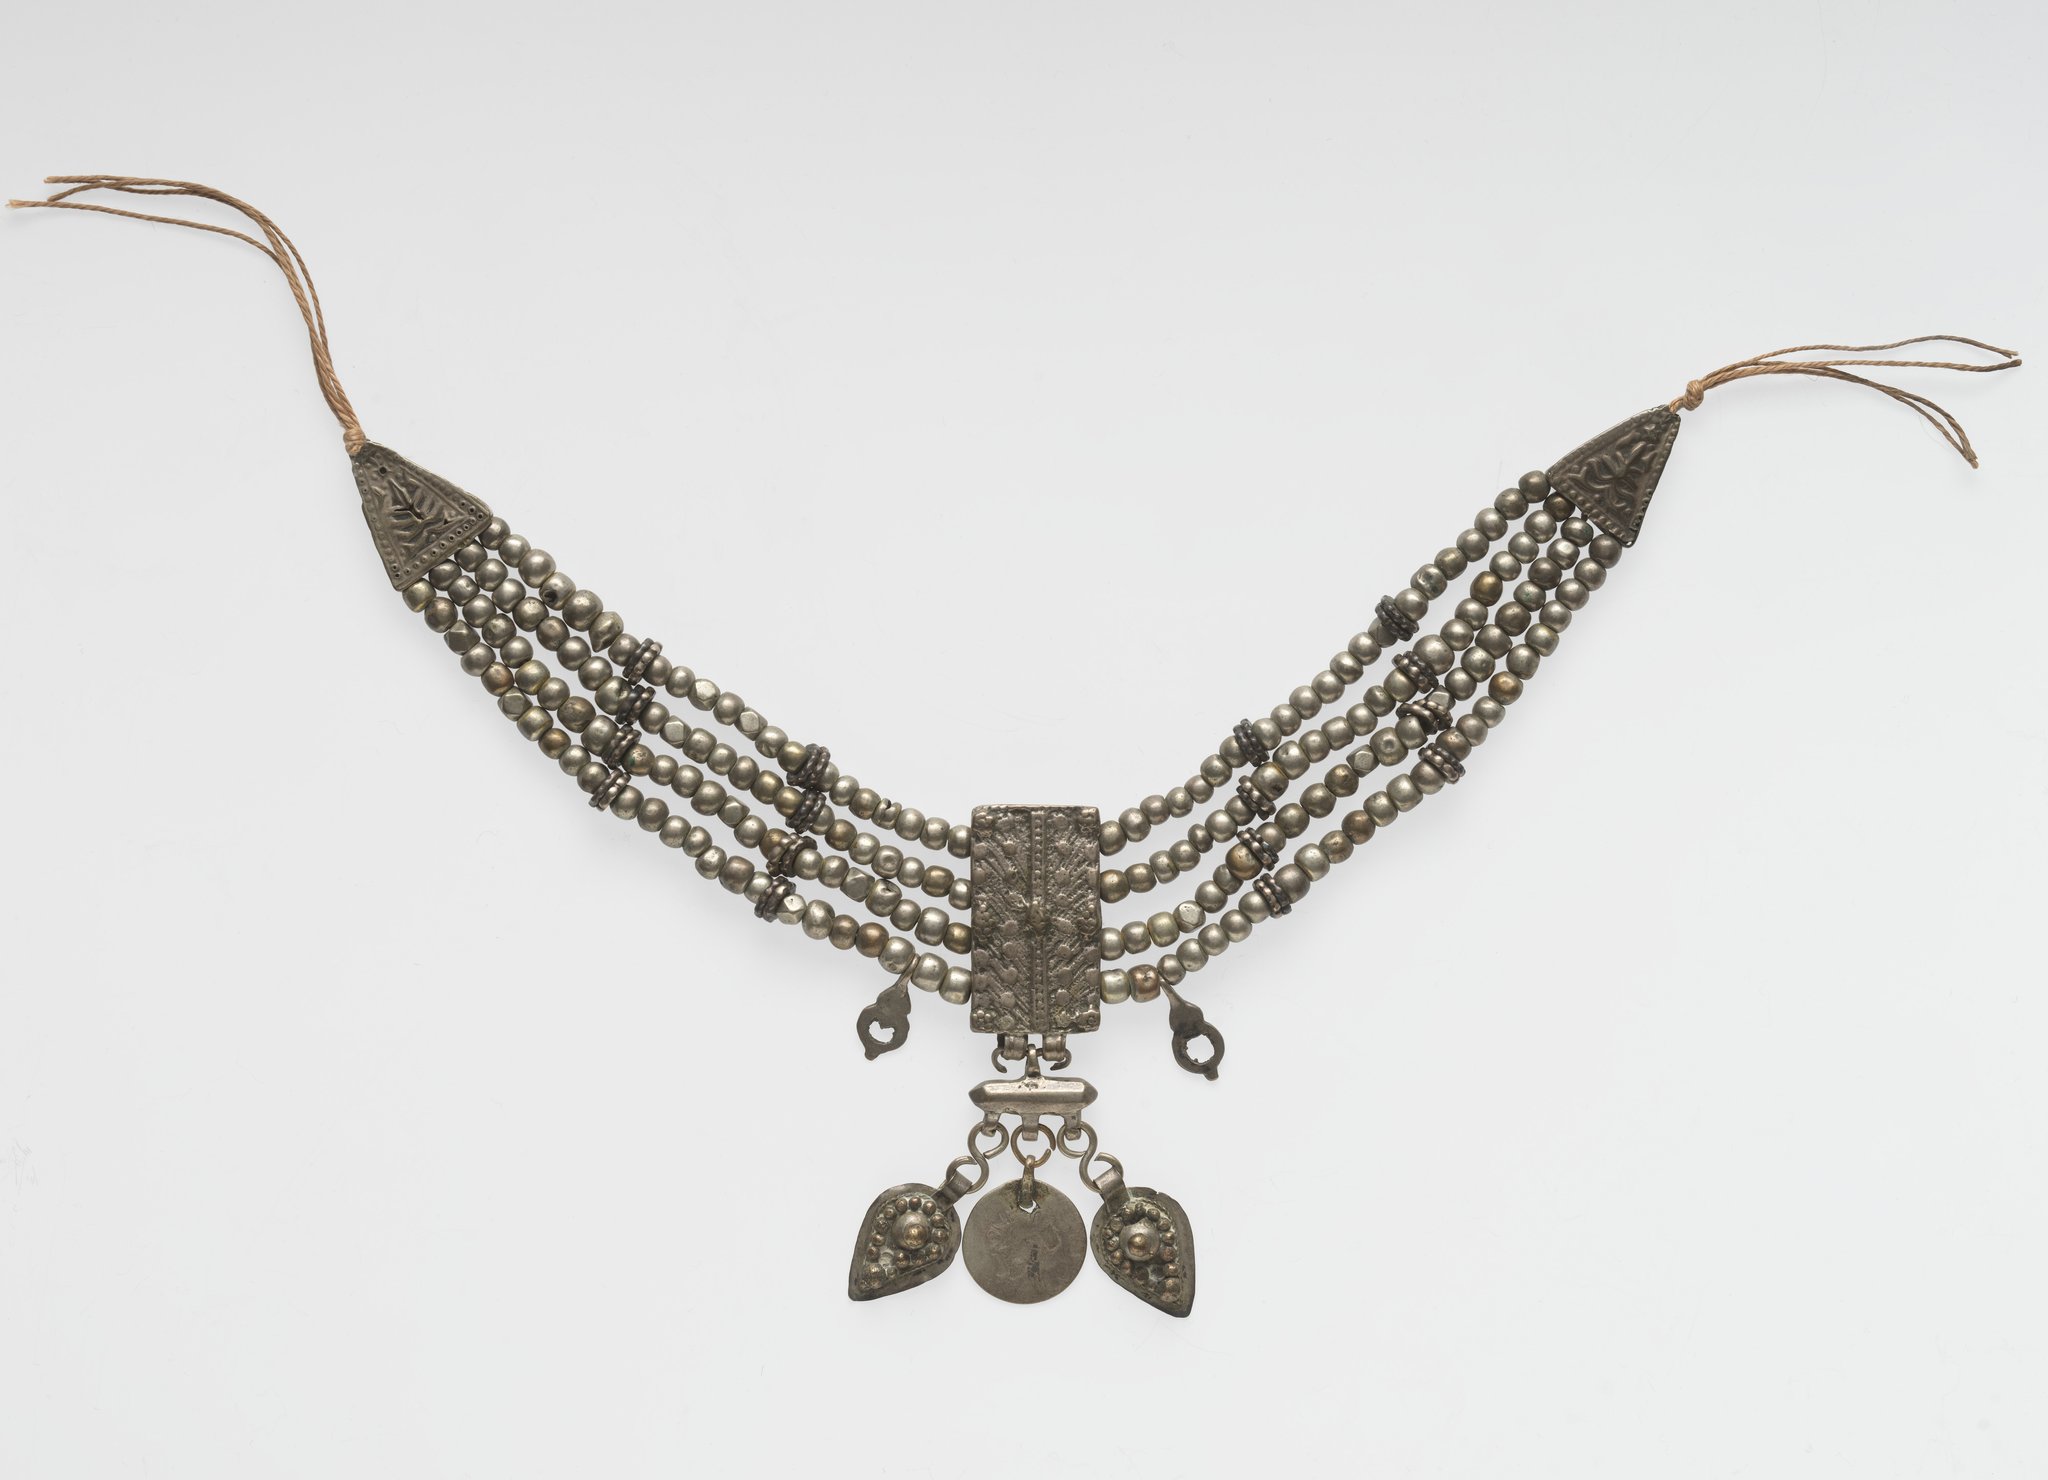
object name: necklace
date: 1801-1900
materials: silver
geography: yemen